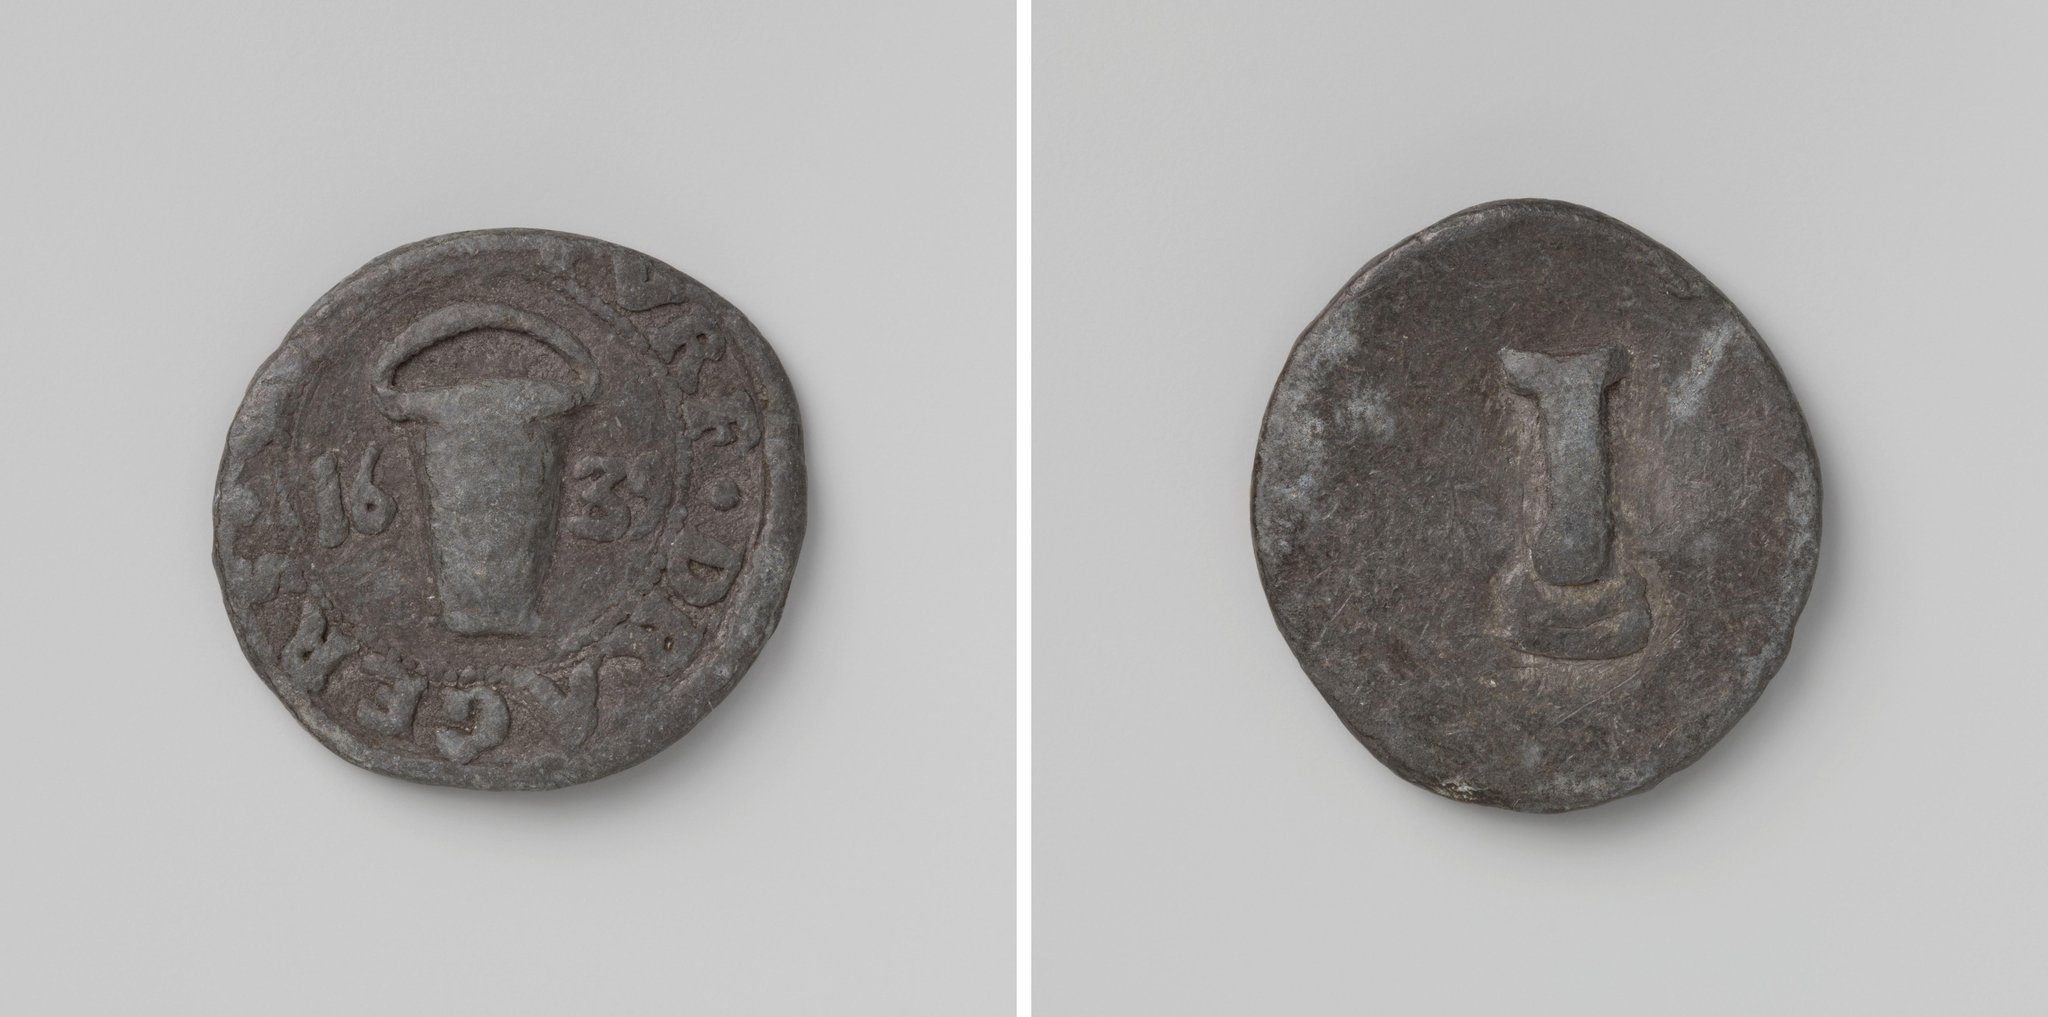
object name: presentiepenning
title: Turfdragersgilde van Amsterdam, presentiepenning met no. 1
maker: Anonymous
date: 1639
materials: lead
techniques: casting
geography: amsterdam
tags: amsterdam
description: Loden penning. Voorzijde: brandemmer tussen jaartal binnen omschrift. Keerzijde: cijfer 1